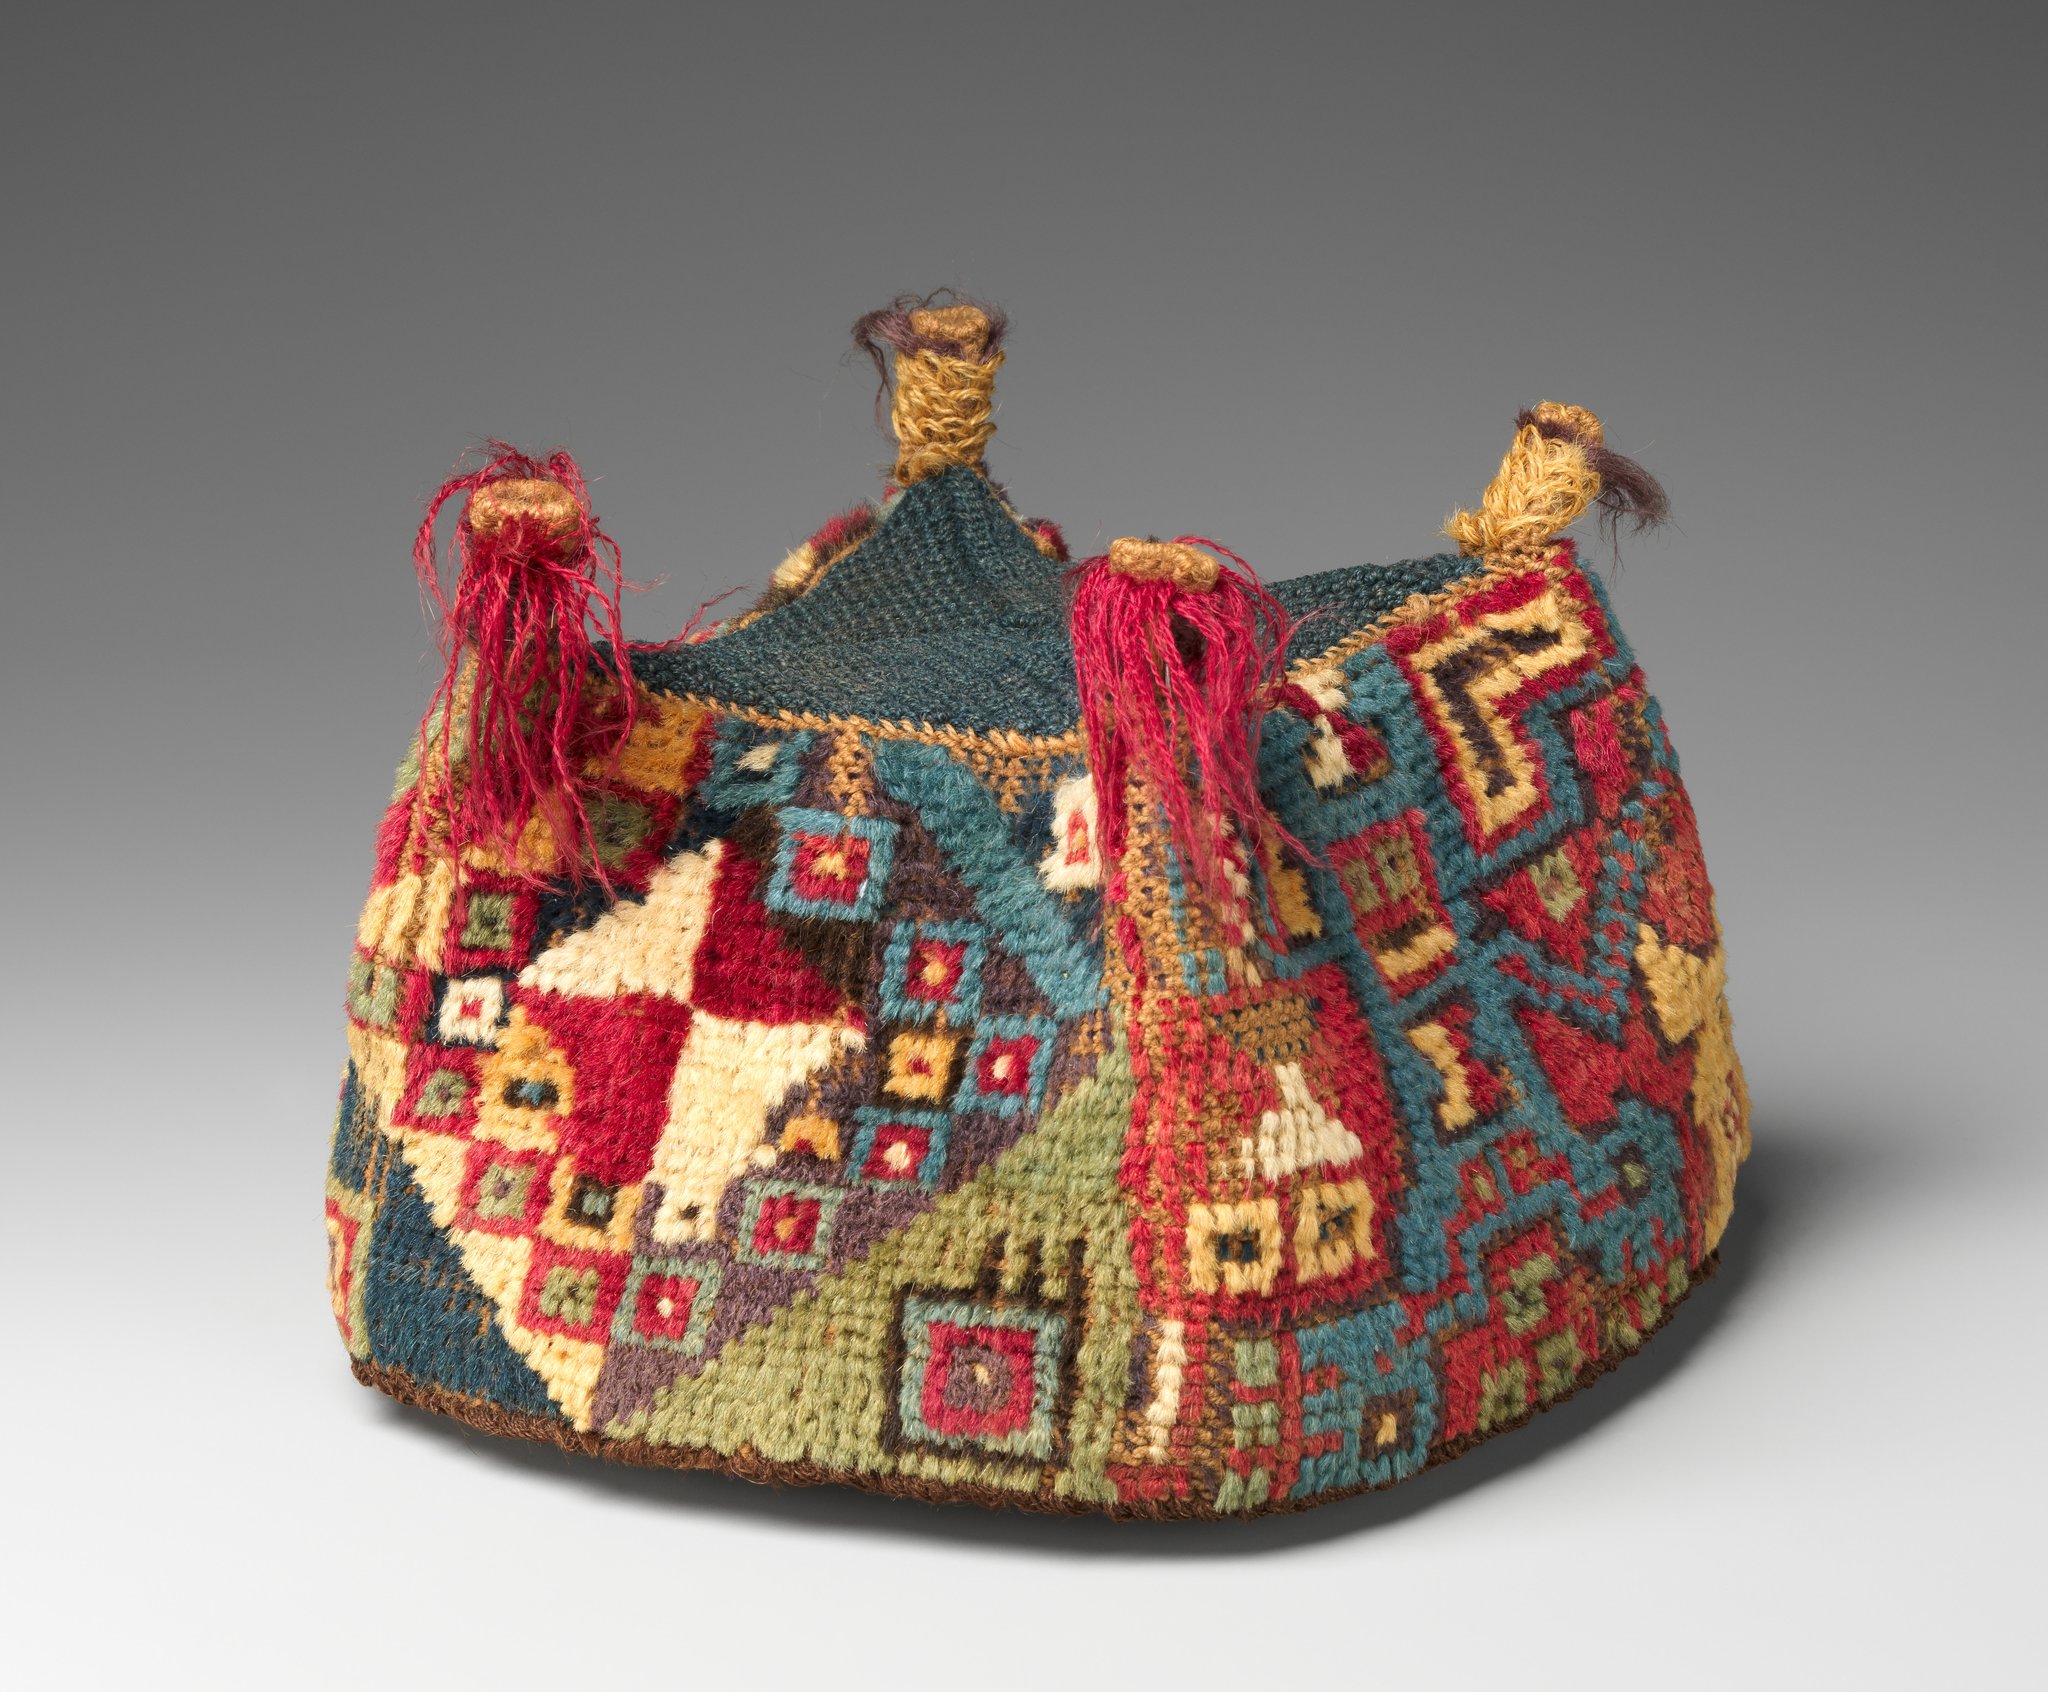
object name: hat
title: Four-Cornered Hat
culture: wari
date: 601-900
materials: animal fiber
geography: peru